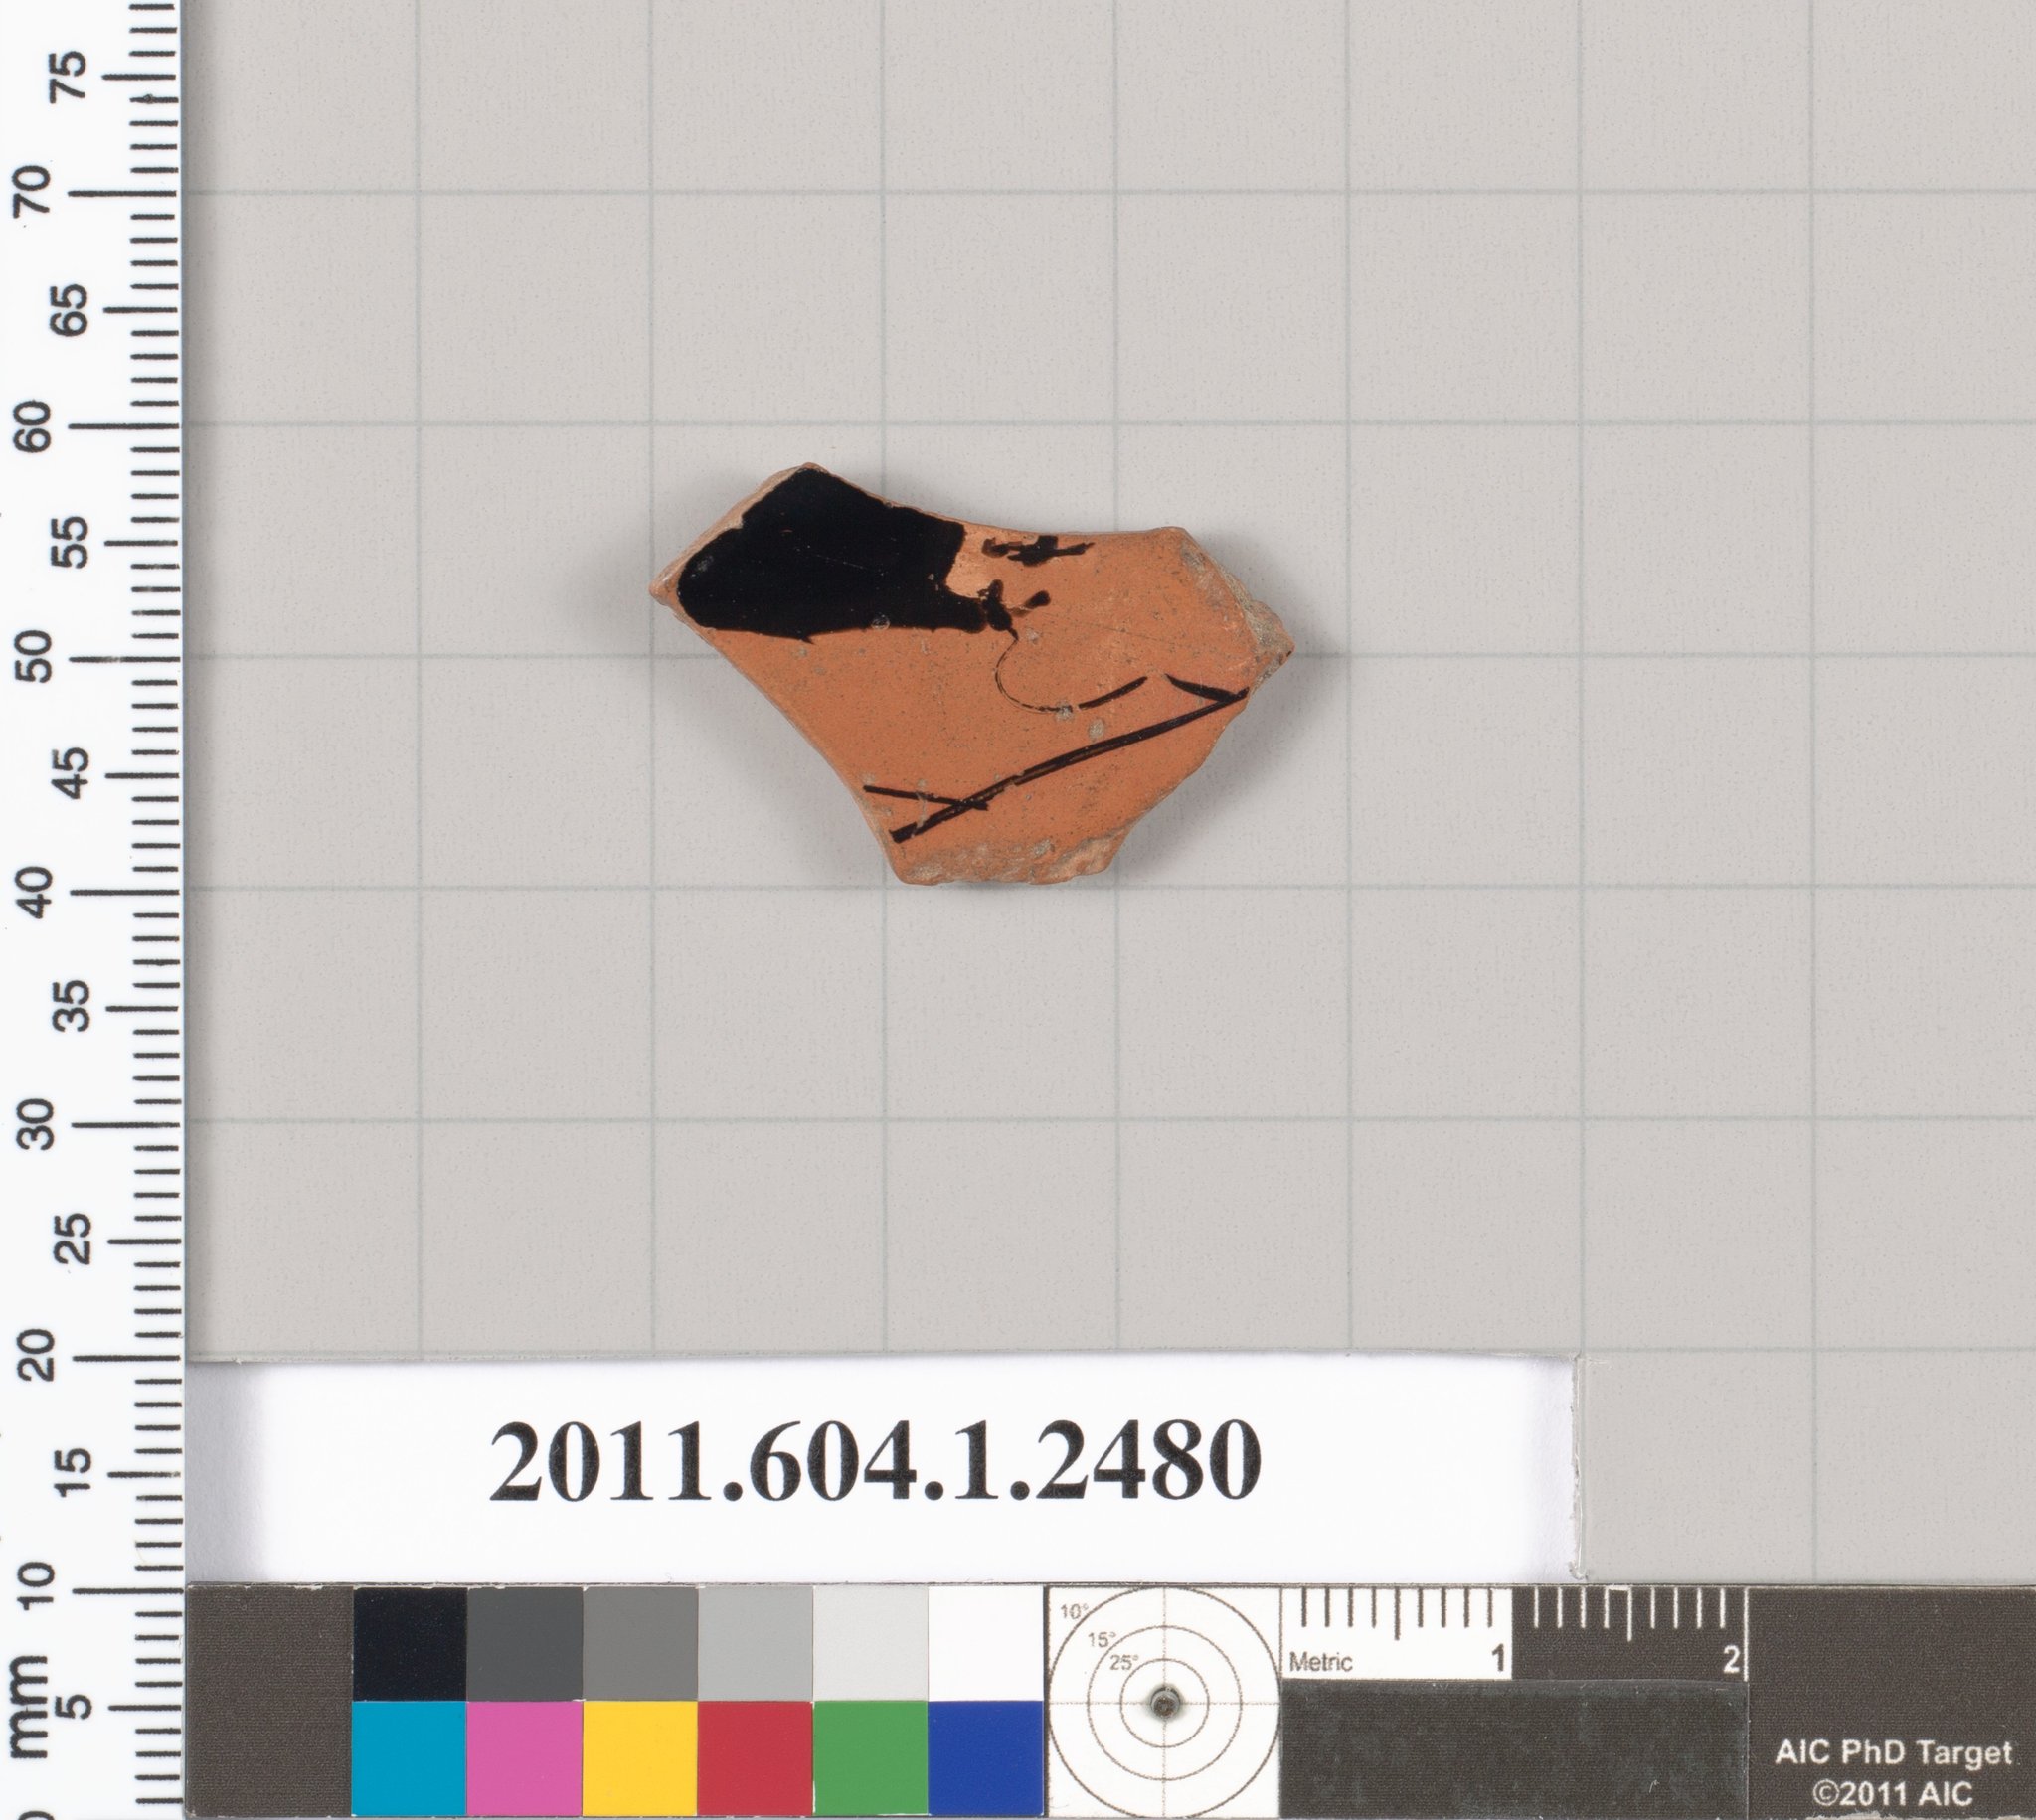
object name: kylix fragment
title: Terracotta fragment of a kylix (drinking cup)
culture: greek, attic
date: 475-451 BCE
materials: terracotta